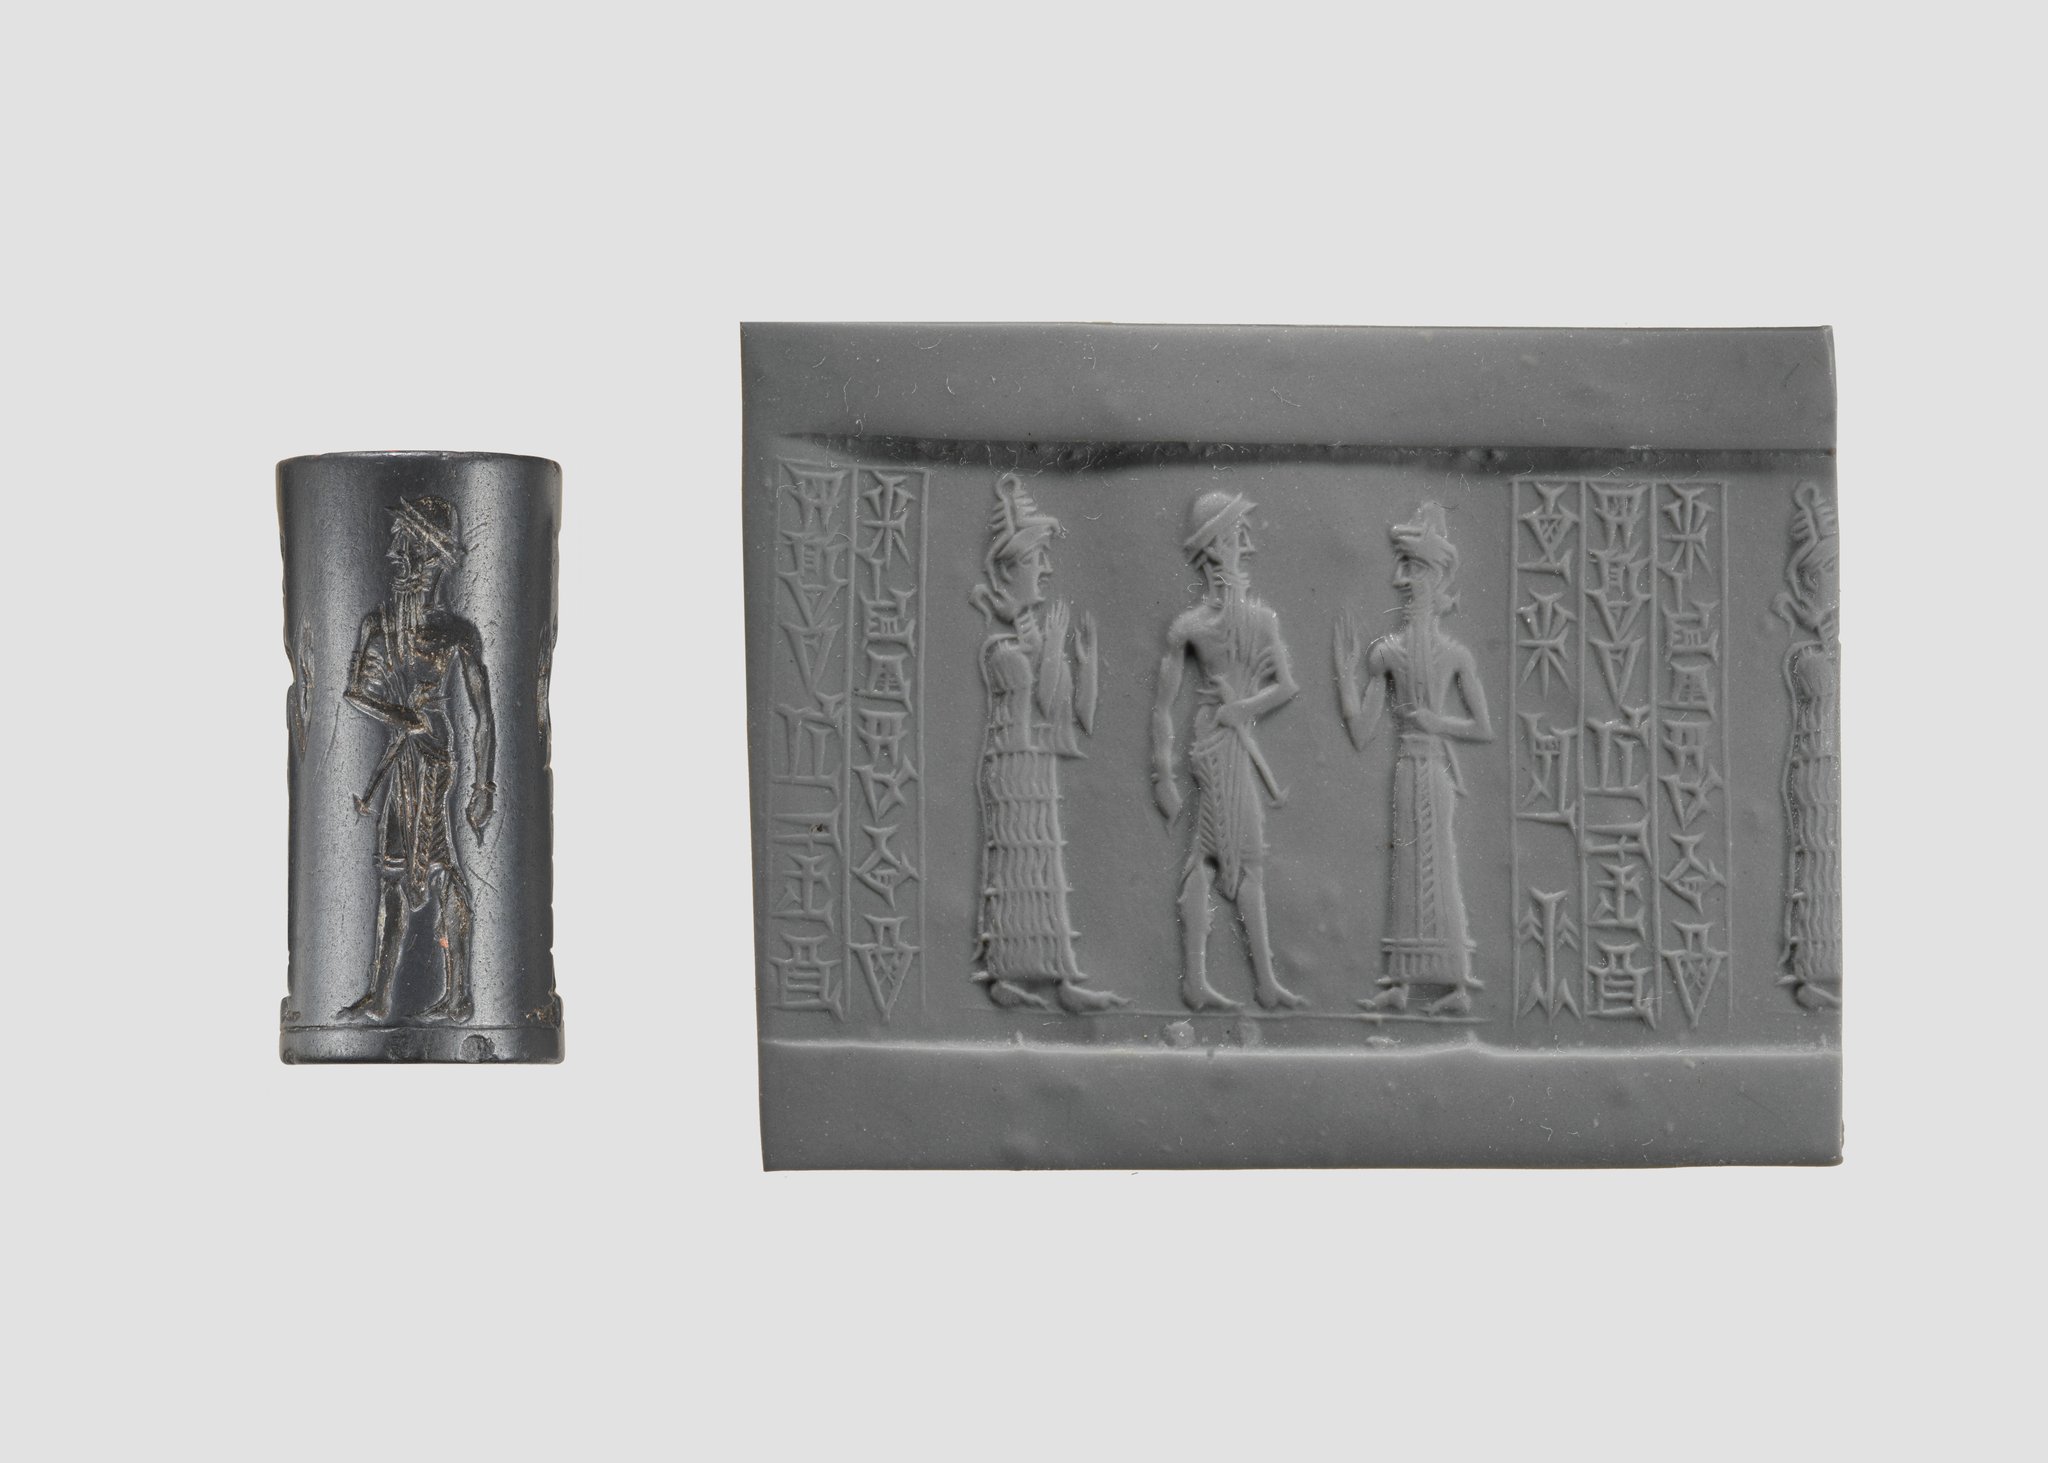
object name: cylinder seal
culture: babylonian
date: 2000-1668 BCE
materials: mineral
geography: mesopotamia